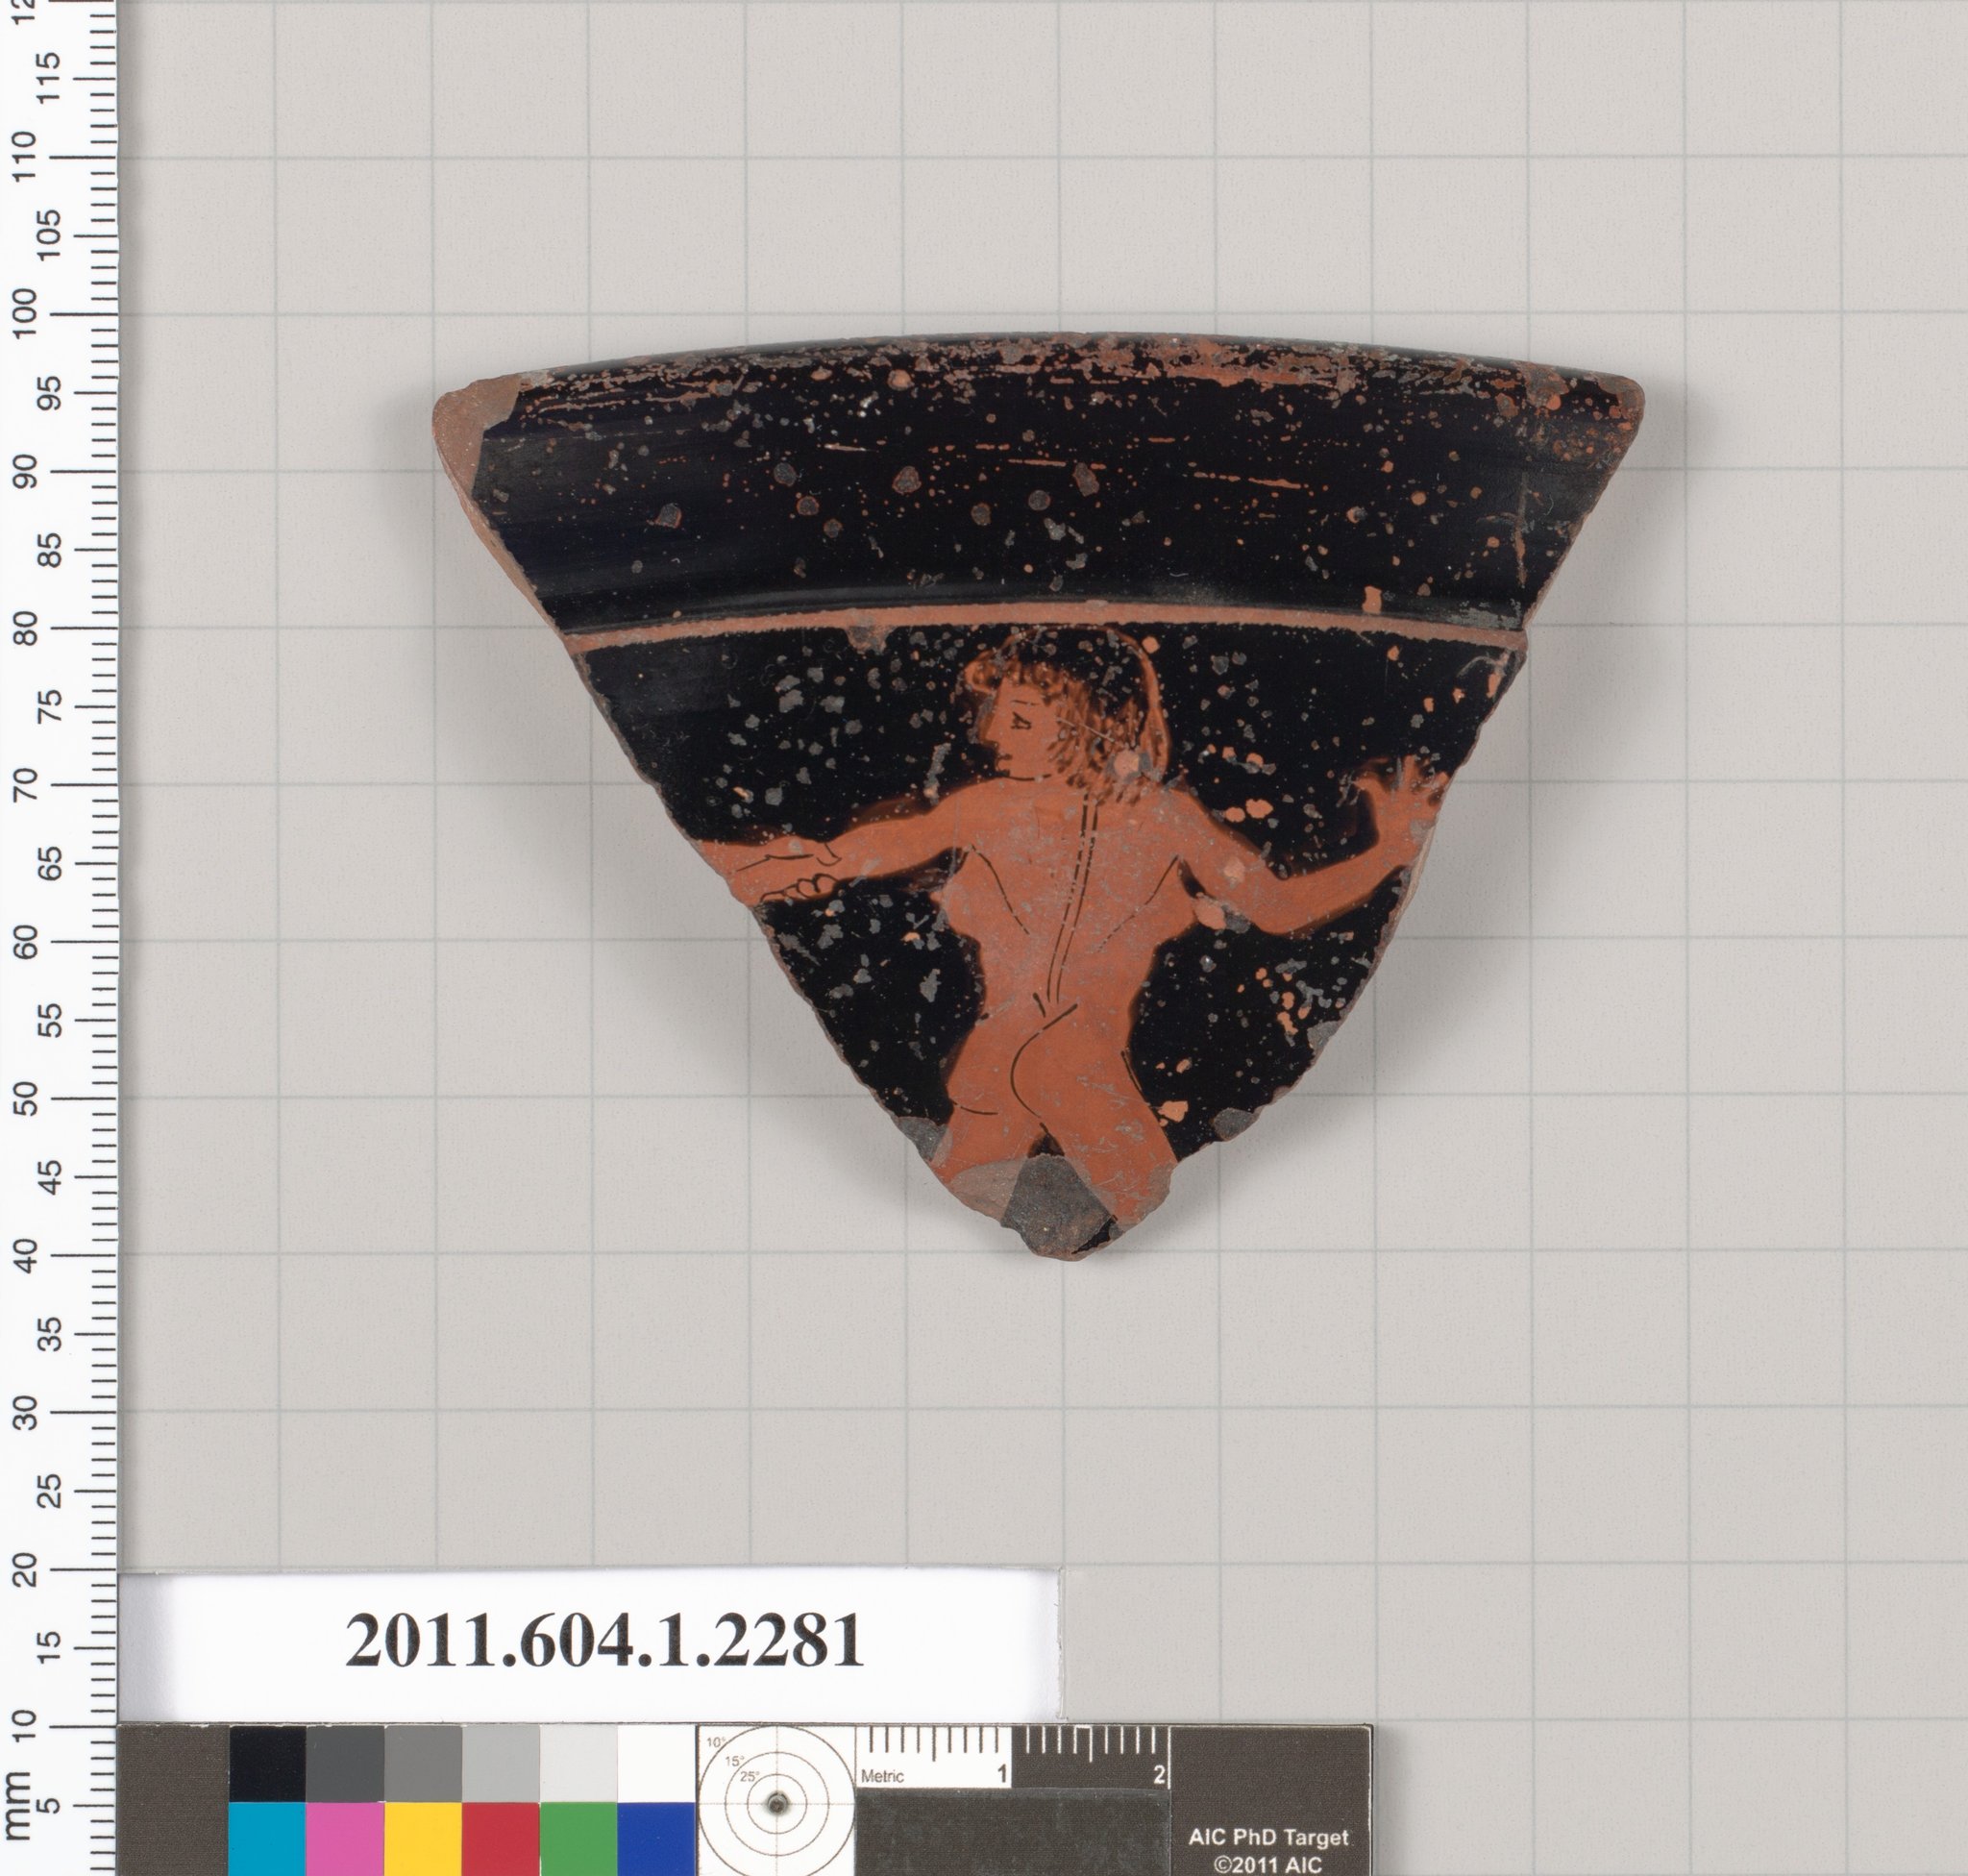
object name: kylix fragment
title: Terracotta rim fragment of a kylix (drinking cup)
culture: greek, attic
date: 475-451 BCE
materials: terracotta